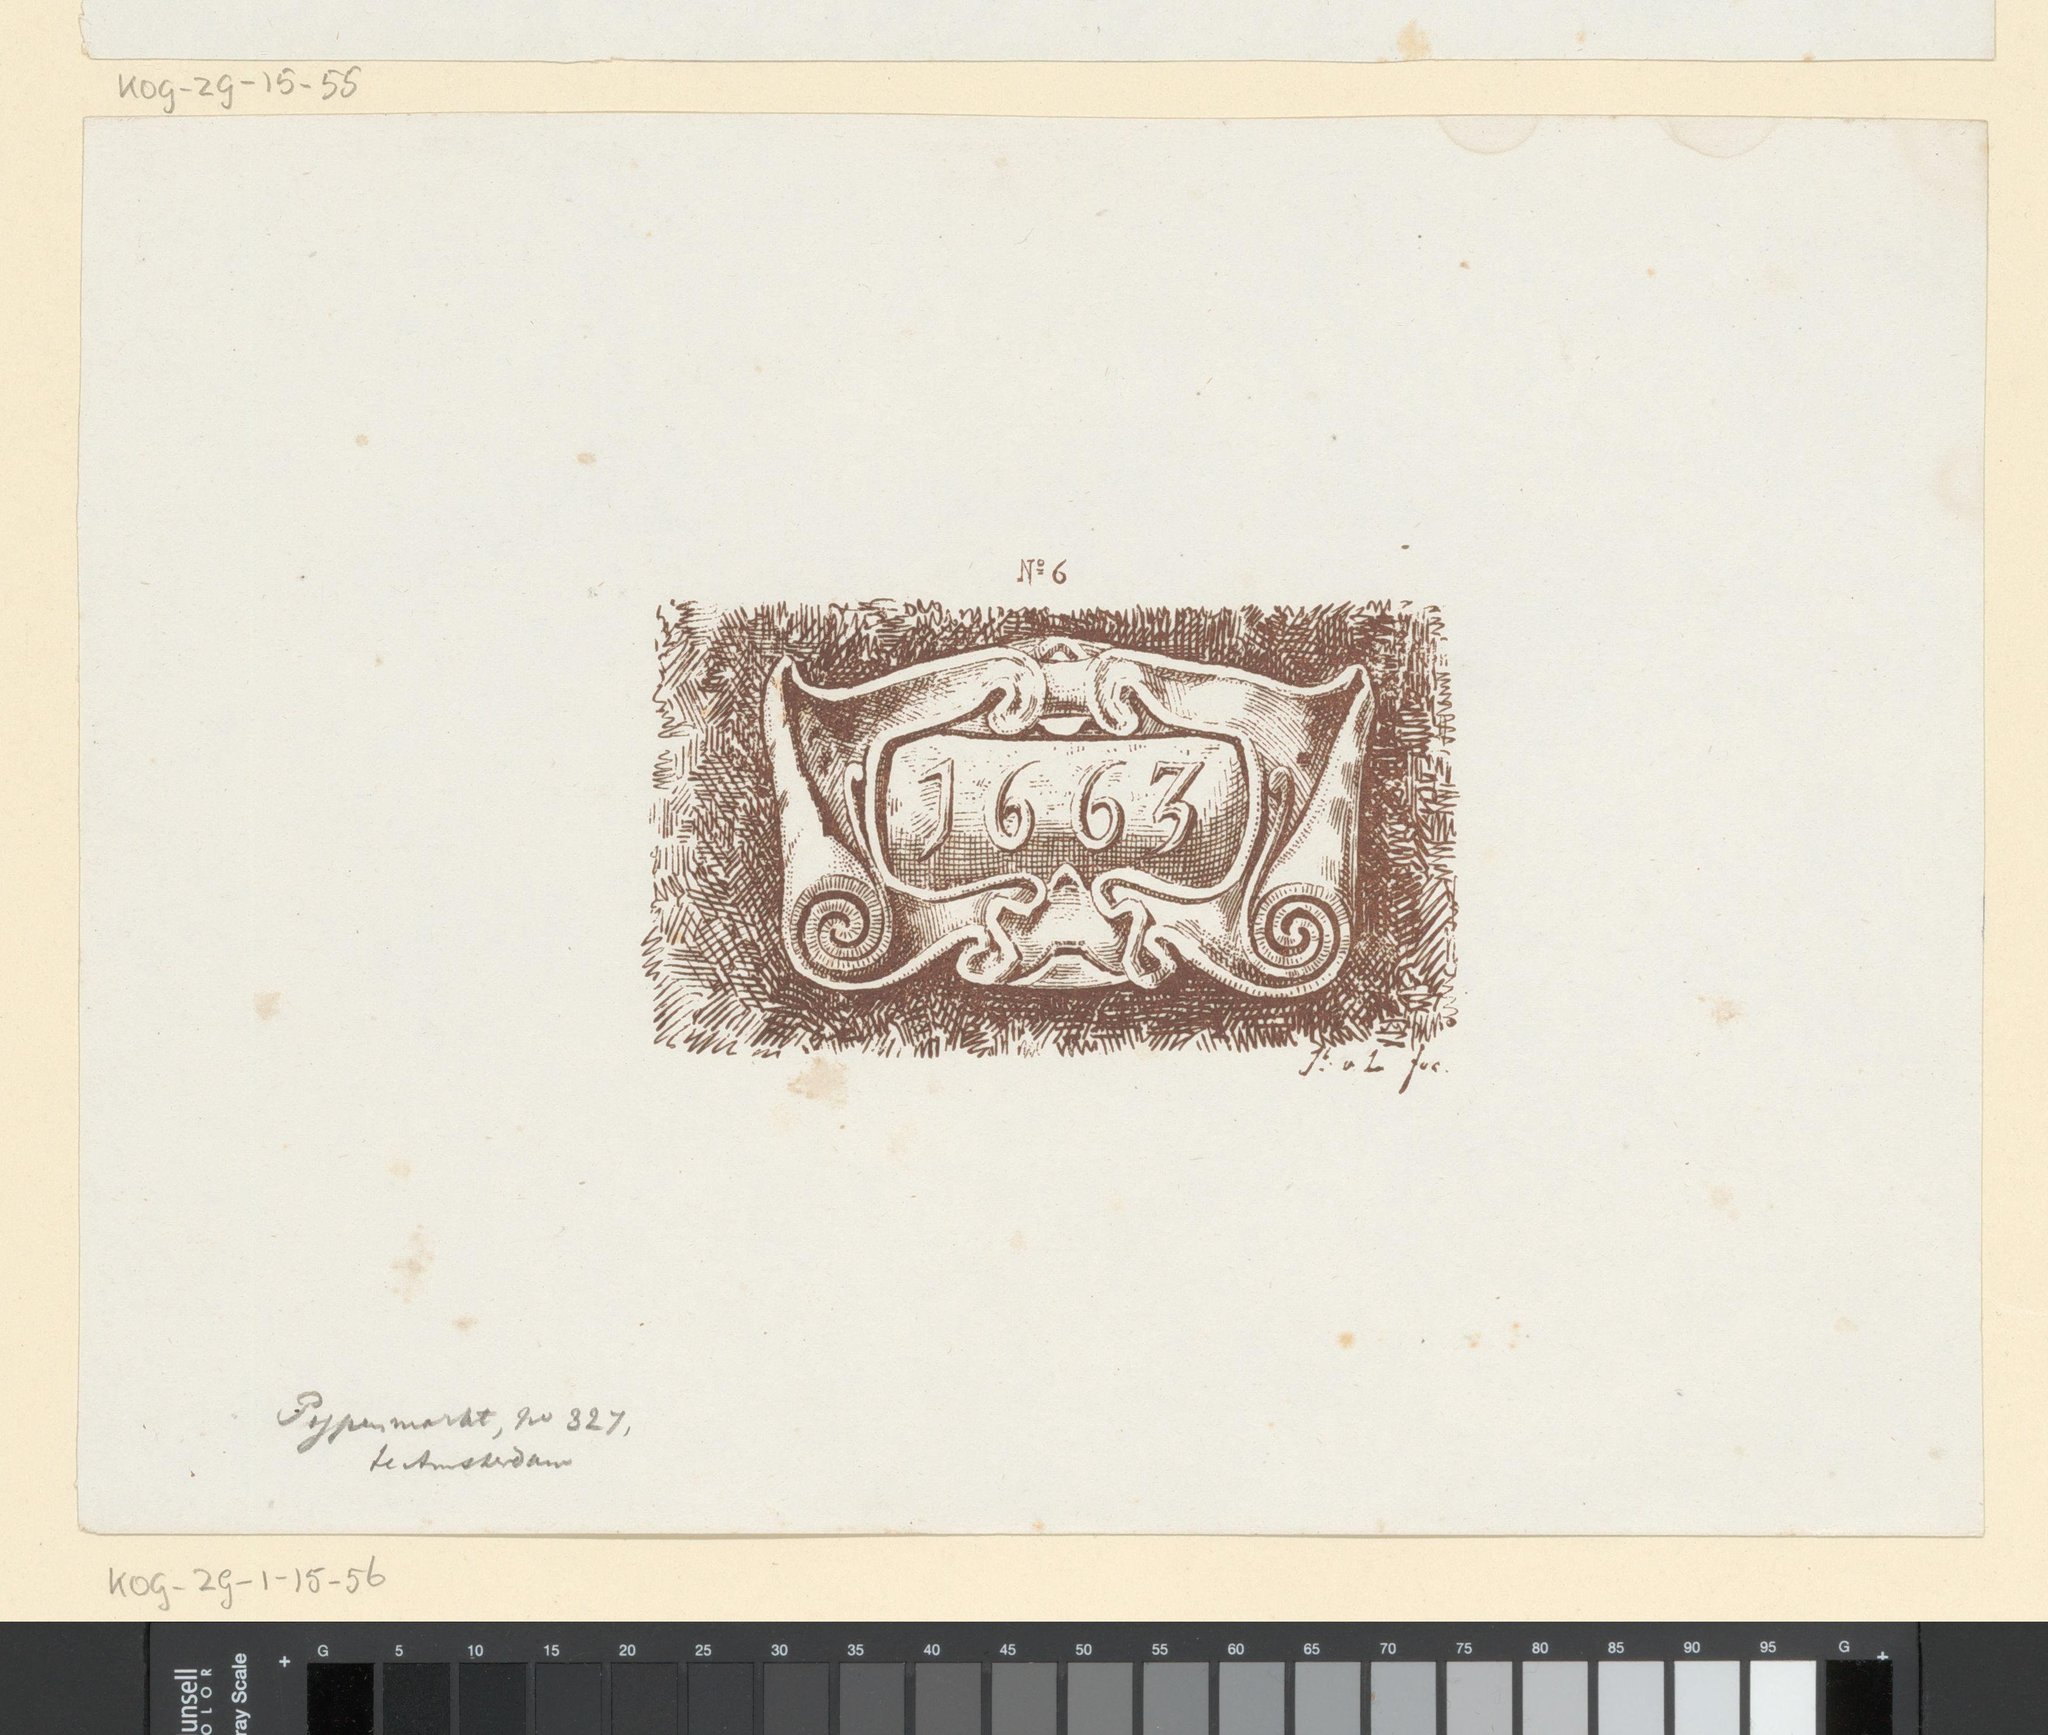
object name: print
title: Cartouche met het jaartal 1663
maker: jac van looij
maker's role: draughtsman, painter, print maker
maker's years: 1855-1930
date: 1877-1880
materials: paper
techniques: lithograph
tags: ornament ~ cartouche, amsterdam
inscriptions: collector's mark: Lugt 1641, stamp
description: Cartouche met het jaartal 1663 op de voormalige Pijpenmarkt. Genummerd midden boven: No. 6. Onderwerpsrubrieken binnen de Atlas Zeden en Gewoonten: Handel, nijverheid en verkeer, Uithangteekens, gevelstenen.